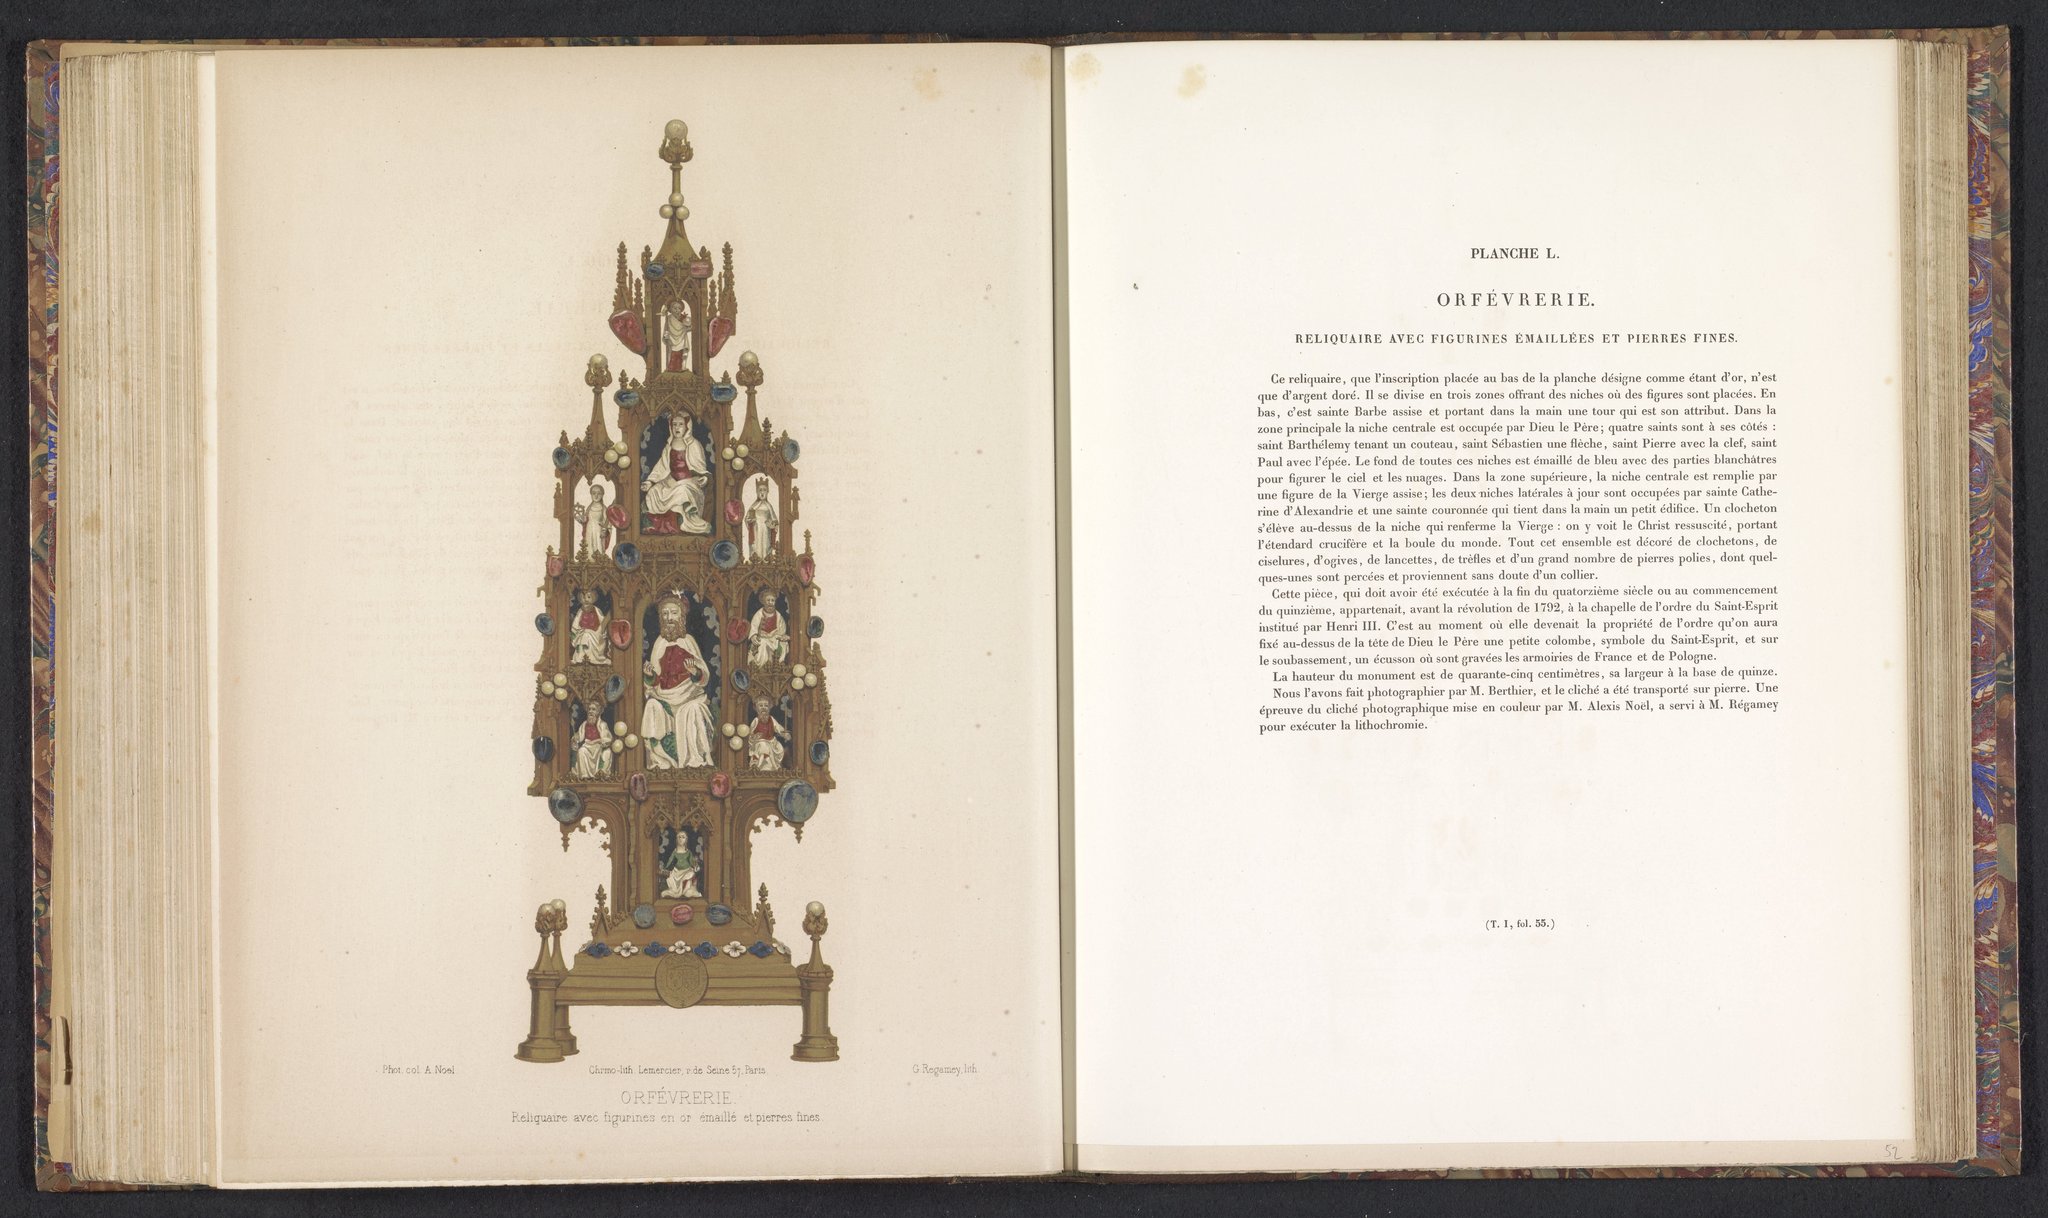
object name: page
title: Orfévrerie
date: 1859-1864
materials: paper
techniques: chromolithography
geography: paris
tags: relics (and reliquaries)